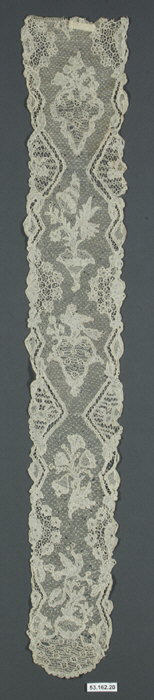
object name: lappet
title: Lappets (one of a pair)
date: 1701-1800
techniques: lace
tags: birds,flowers